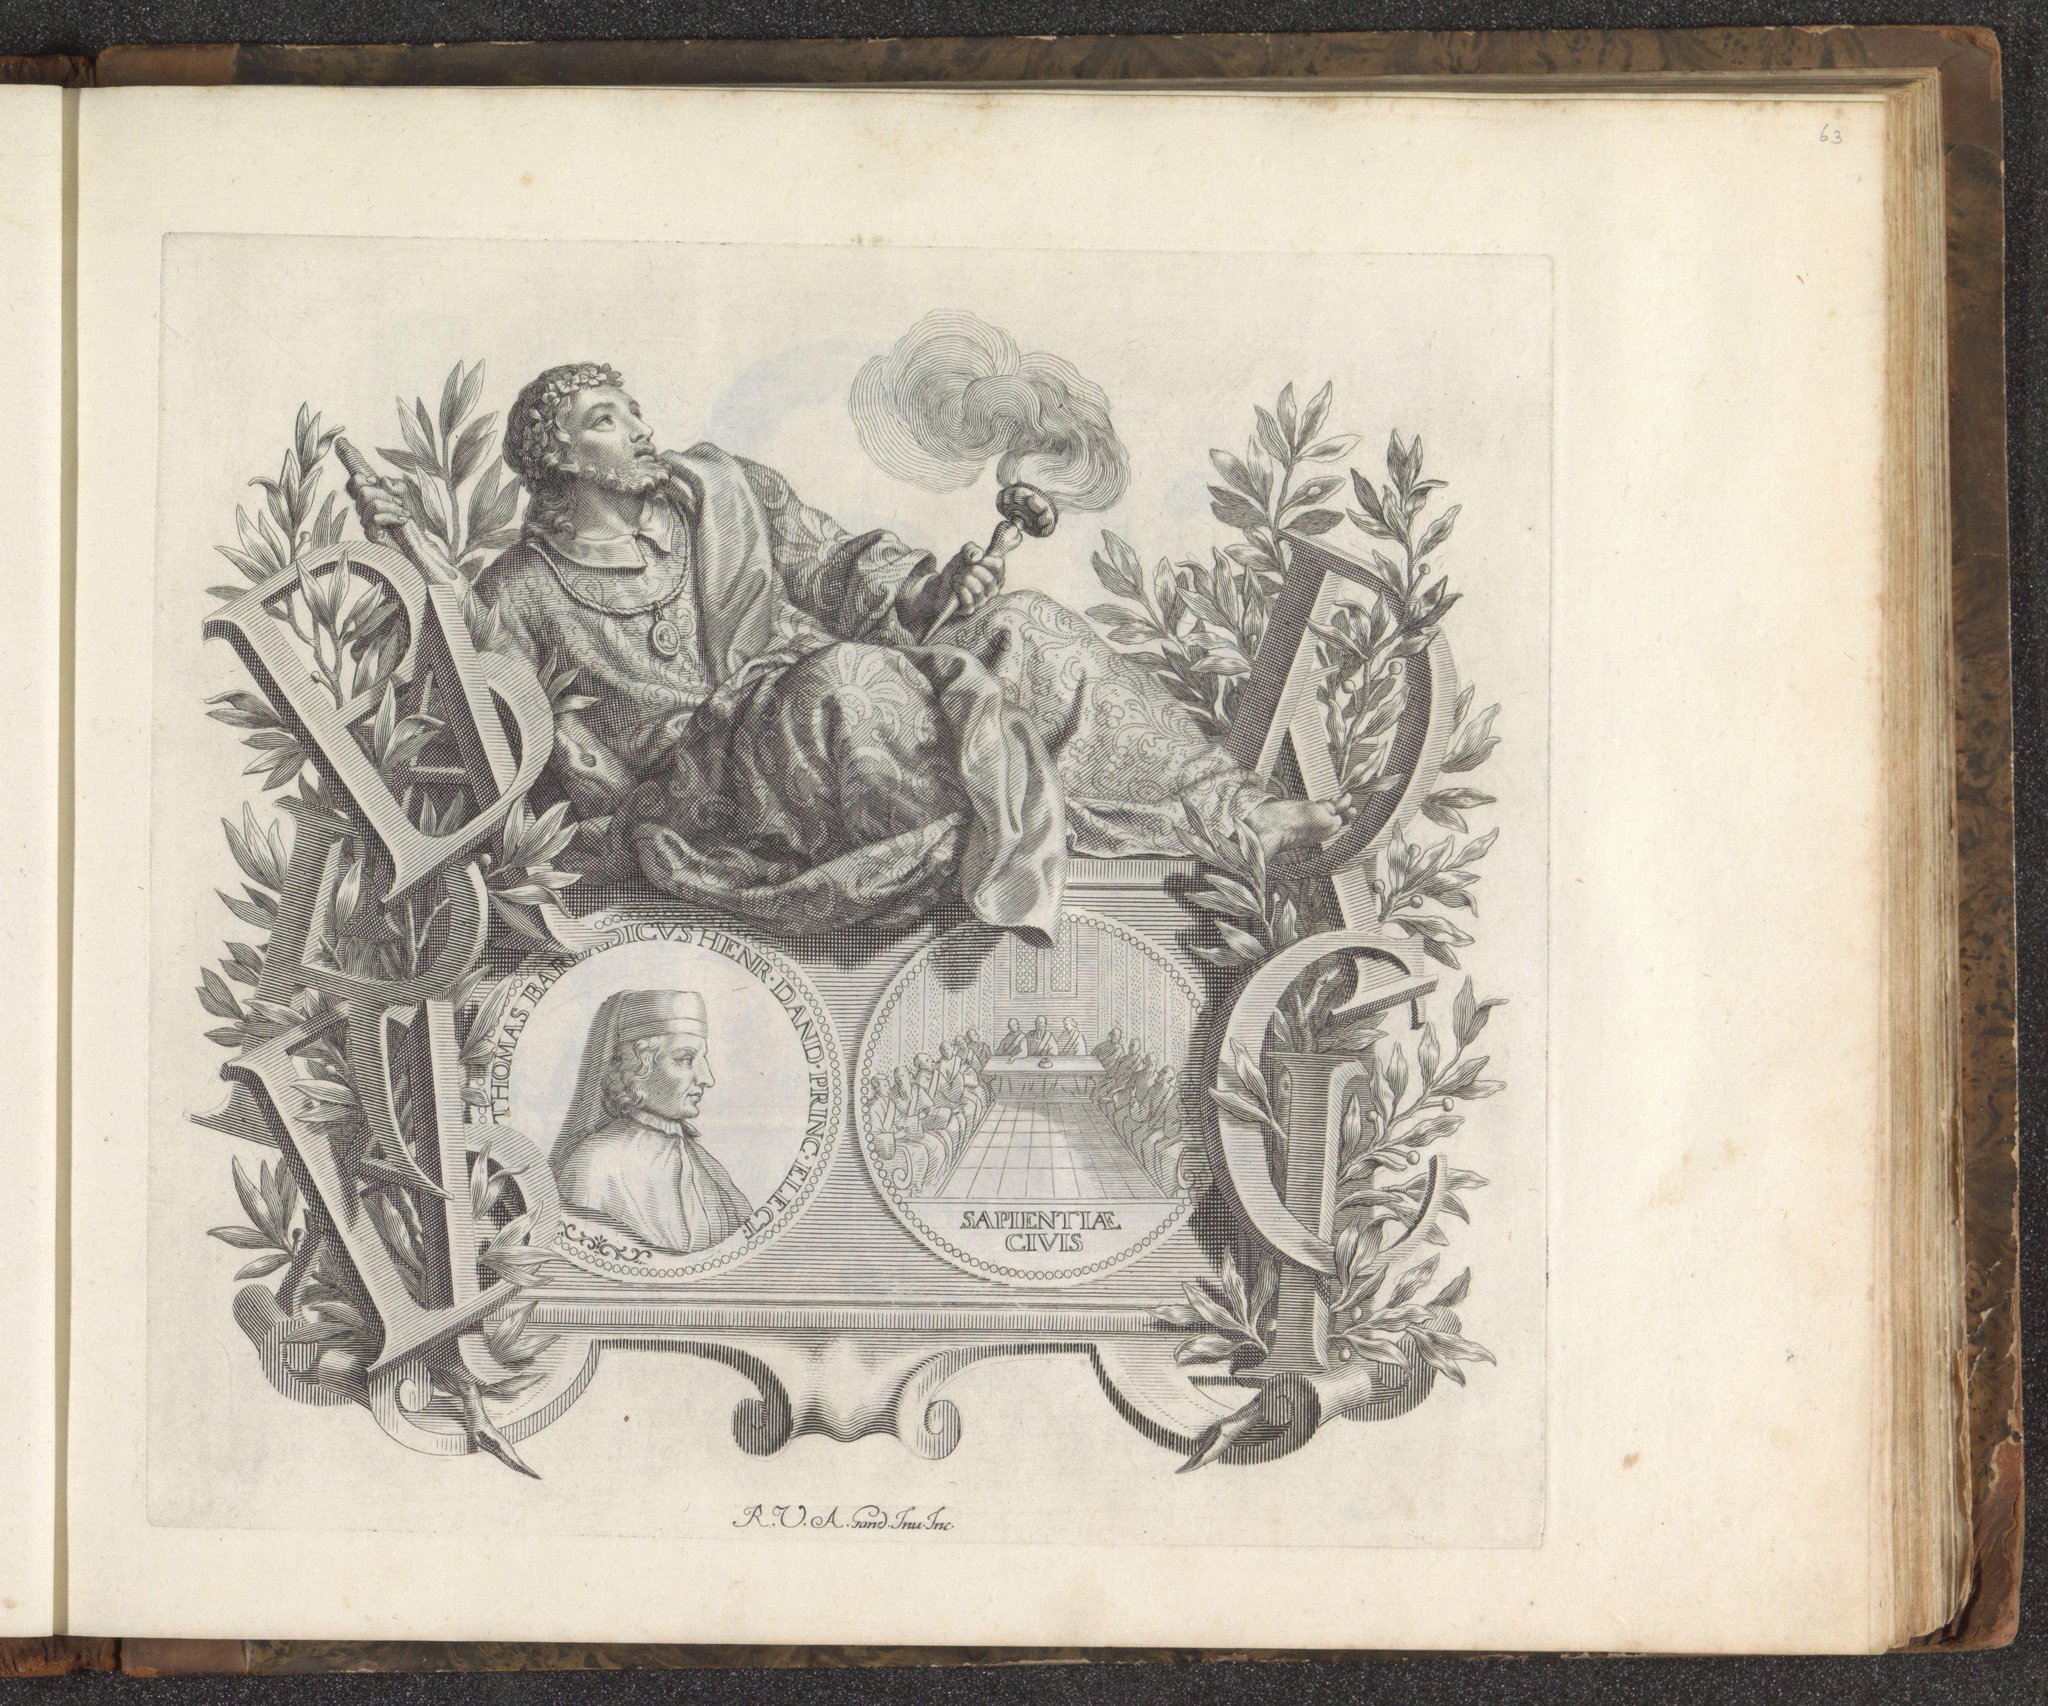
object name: print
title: Numismata virorum illustrium ex Barbadica gente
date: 1673-1743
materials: paper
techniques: engraving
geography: rome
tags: medal (considered as a piece of sculpture, regardless of its specific function), upper house, senate, repute, renown; 'splendore del nome' (ripa)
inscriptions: collector's mark: Lugt 2228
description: Voetstuk in de vorm van een cartouche. Daarop een medaillon met op de voorkant het portret van Tommaso Barbarigo. Hij leefde ten tijde van Enrico Dandolo, doge van Venetië. Op de achterkant de senaat in stemming en de tekst: Sapientiae Civis. Op het voetstuk ligt de personificatie van Roem en Reputatie. Het betreft een man in goudbrokaat, gekroond met een krans van bloemen en om zijn nek een gouden ketting. Hij leunt op de knots van Hercules en heeft in zijn linker hand een fakkel. Hij wordt geflankeerd door lauriertakken en de letters B.A.R.B.A.D.I.G.I. De prent maakt deel uit van een album.